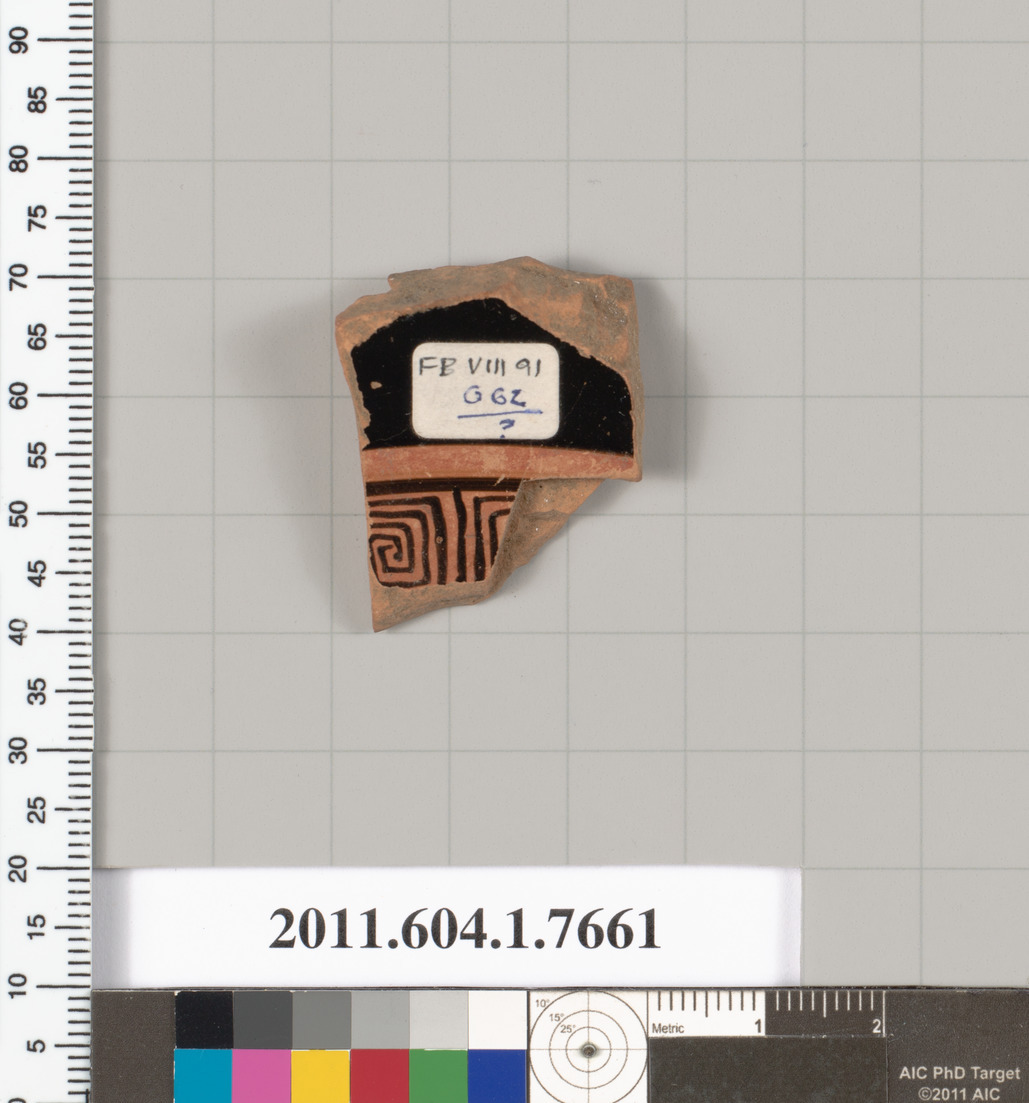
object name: kylix fragment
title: Terracotta fragment of a kylix (drinking cup)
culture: greek, attic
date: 460-450 BCE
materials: terracotta